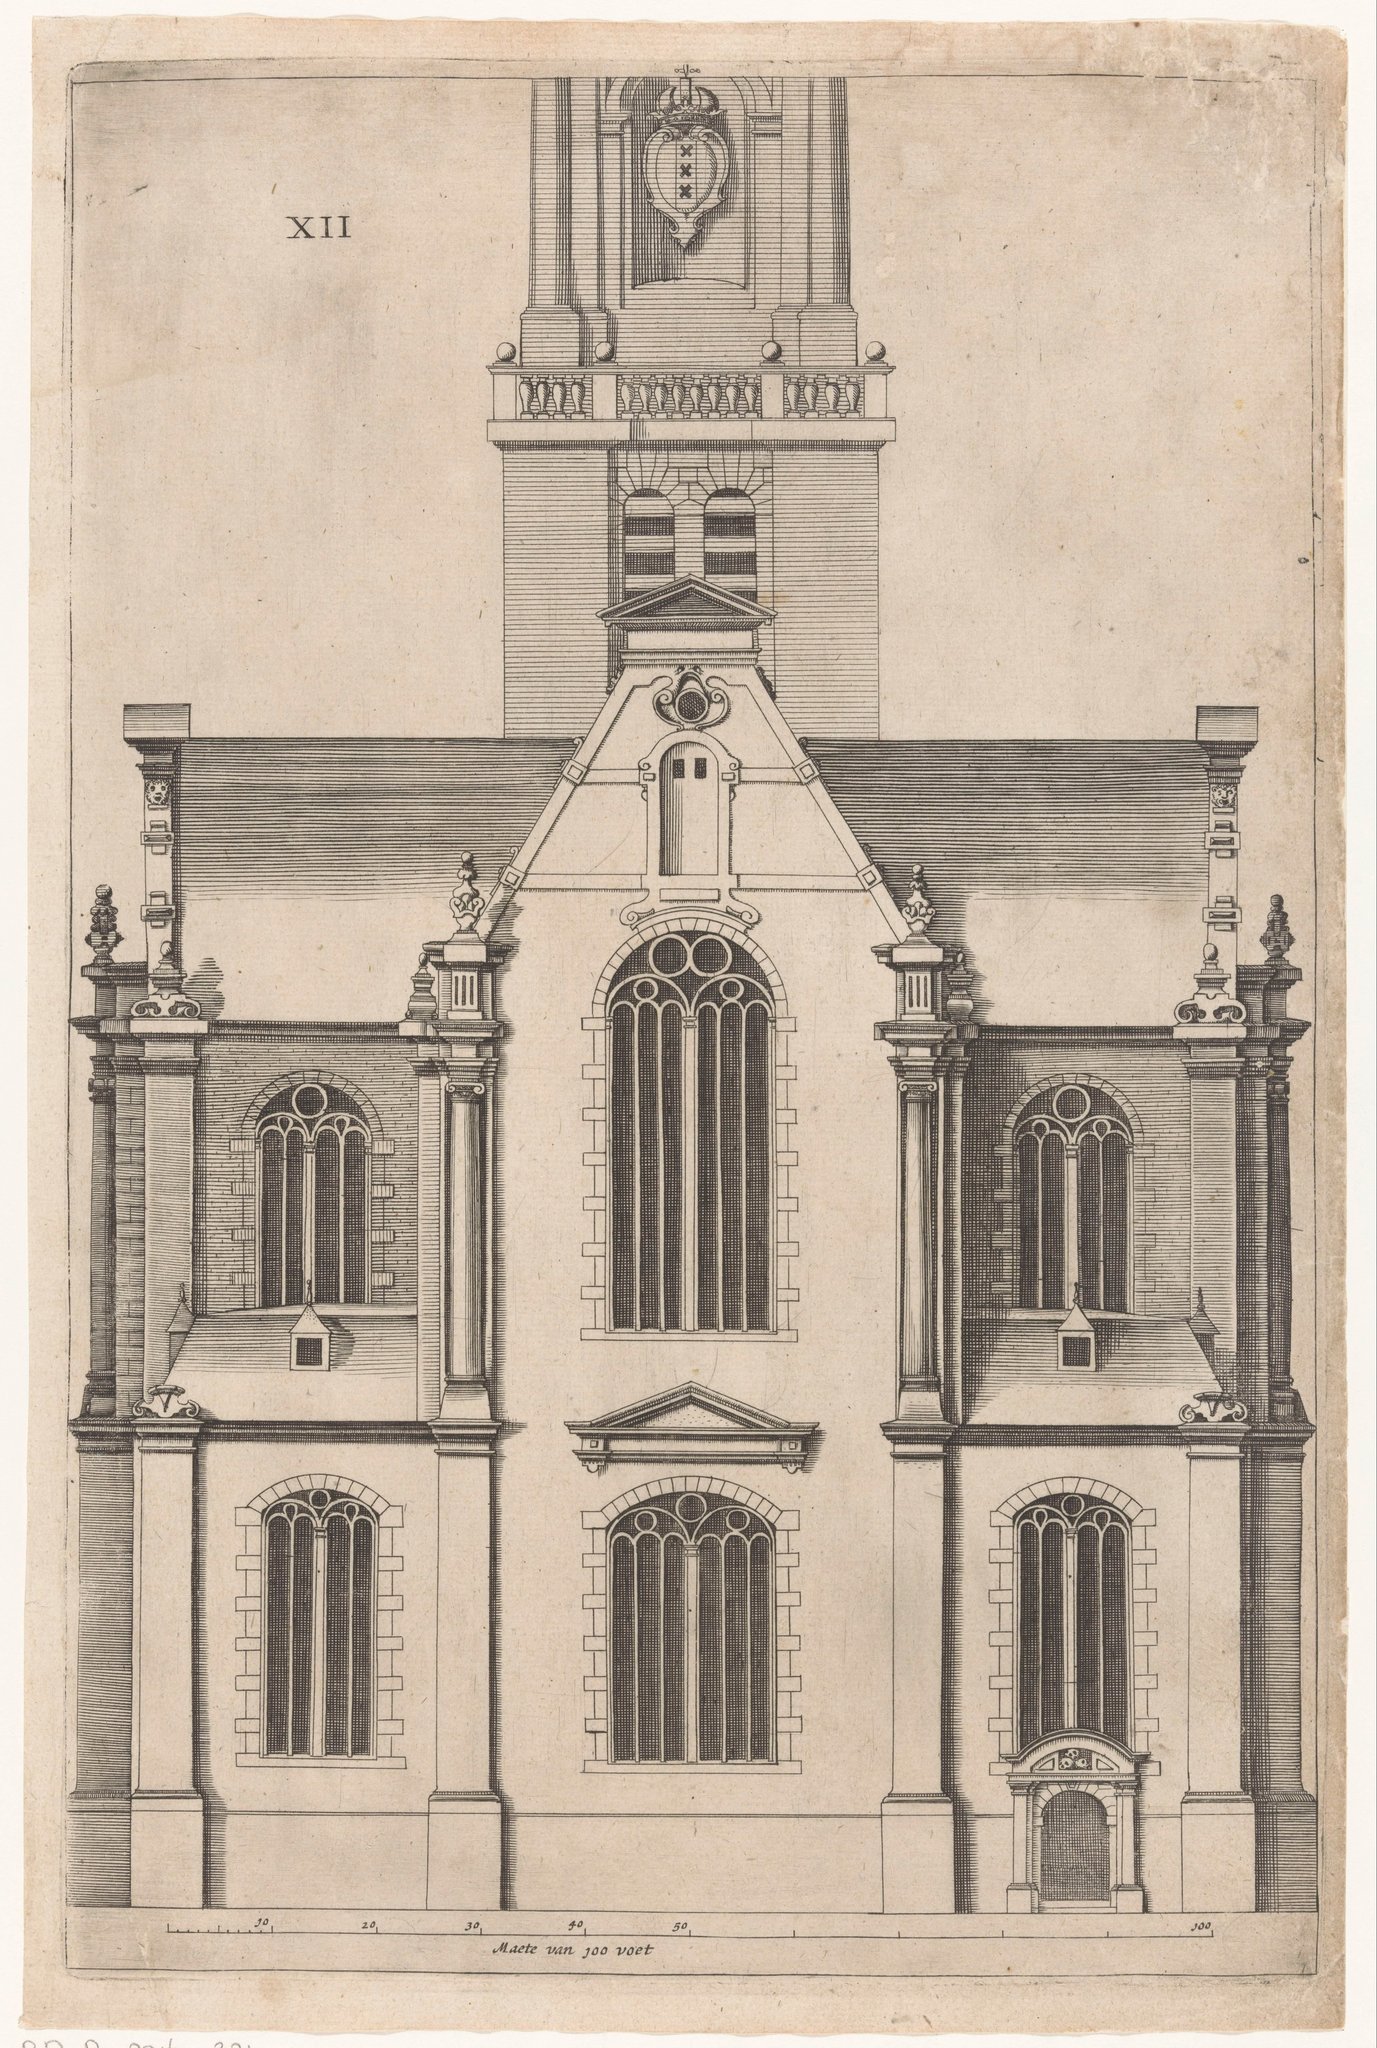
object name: print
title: Architectura moderna ofte Bouwinge van onsen tyt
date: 1631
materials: paper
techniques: engraving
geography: amsterdam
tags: church (exterior), exterior ~ architectural design or model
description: Prent uit: Keyser, Hendrick de. Architectura moderna ofte bouwinge van onsen tyt (...) alle gedaen by (...) Amsterdam: Danckerts, Cornelis, 1631.